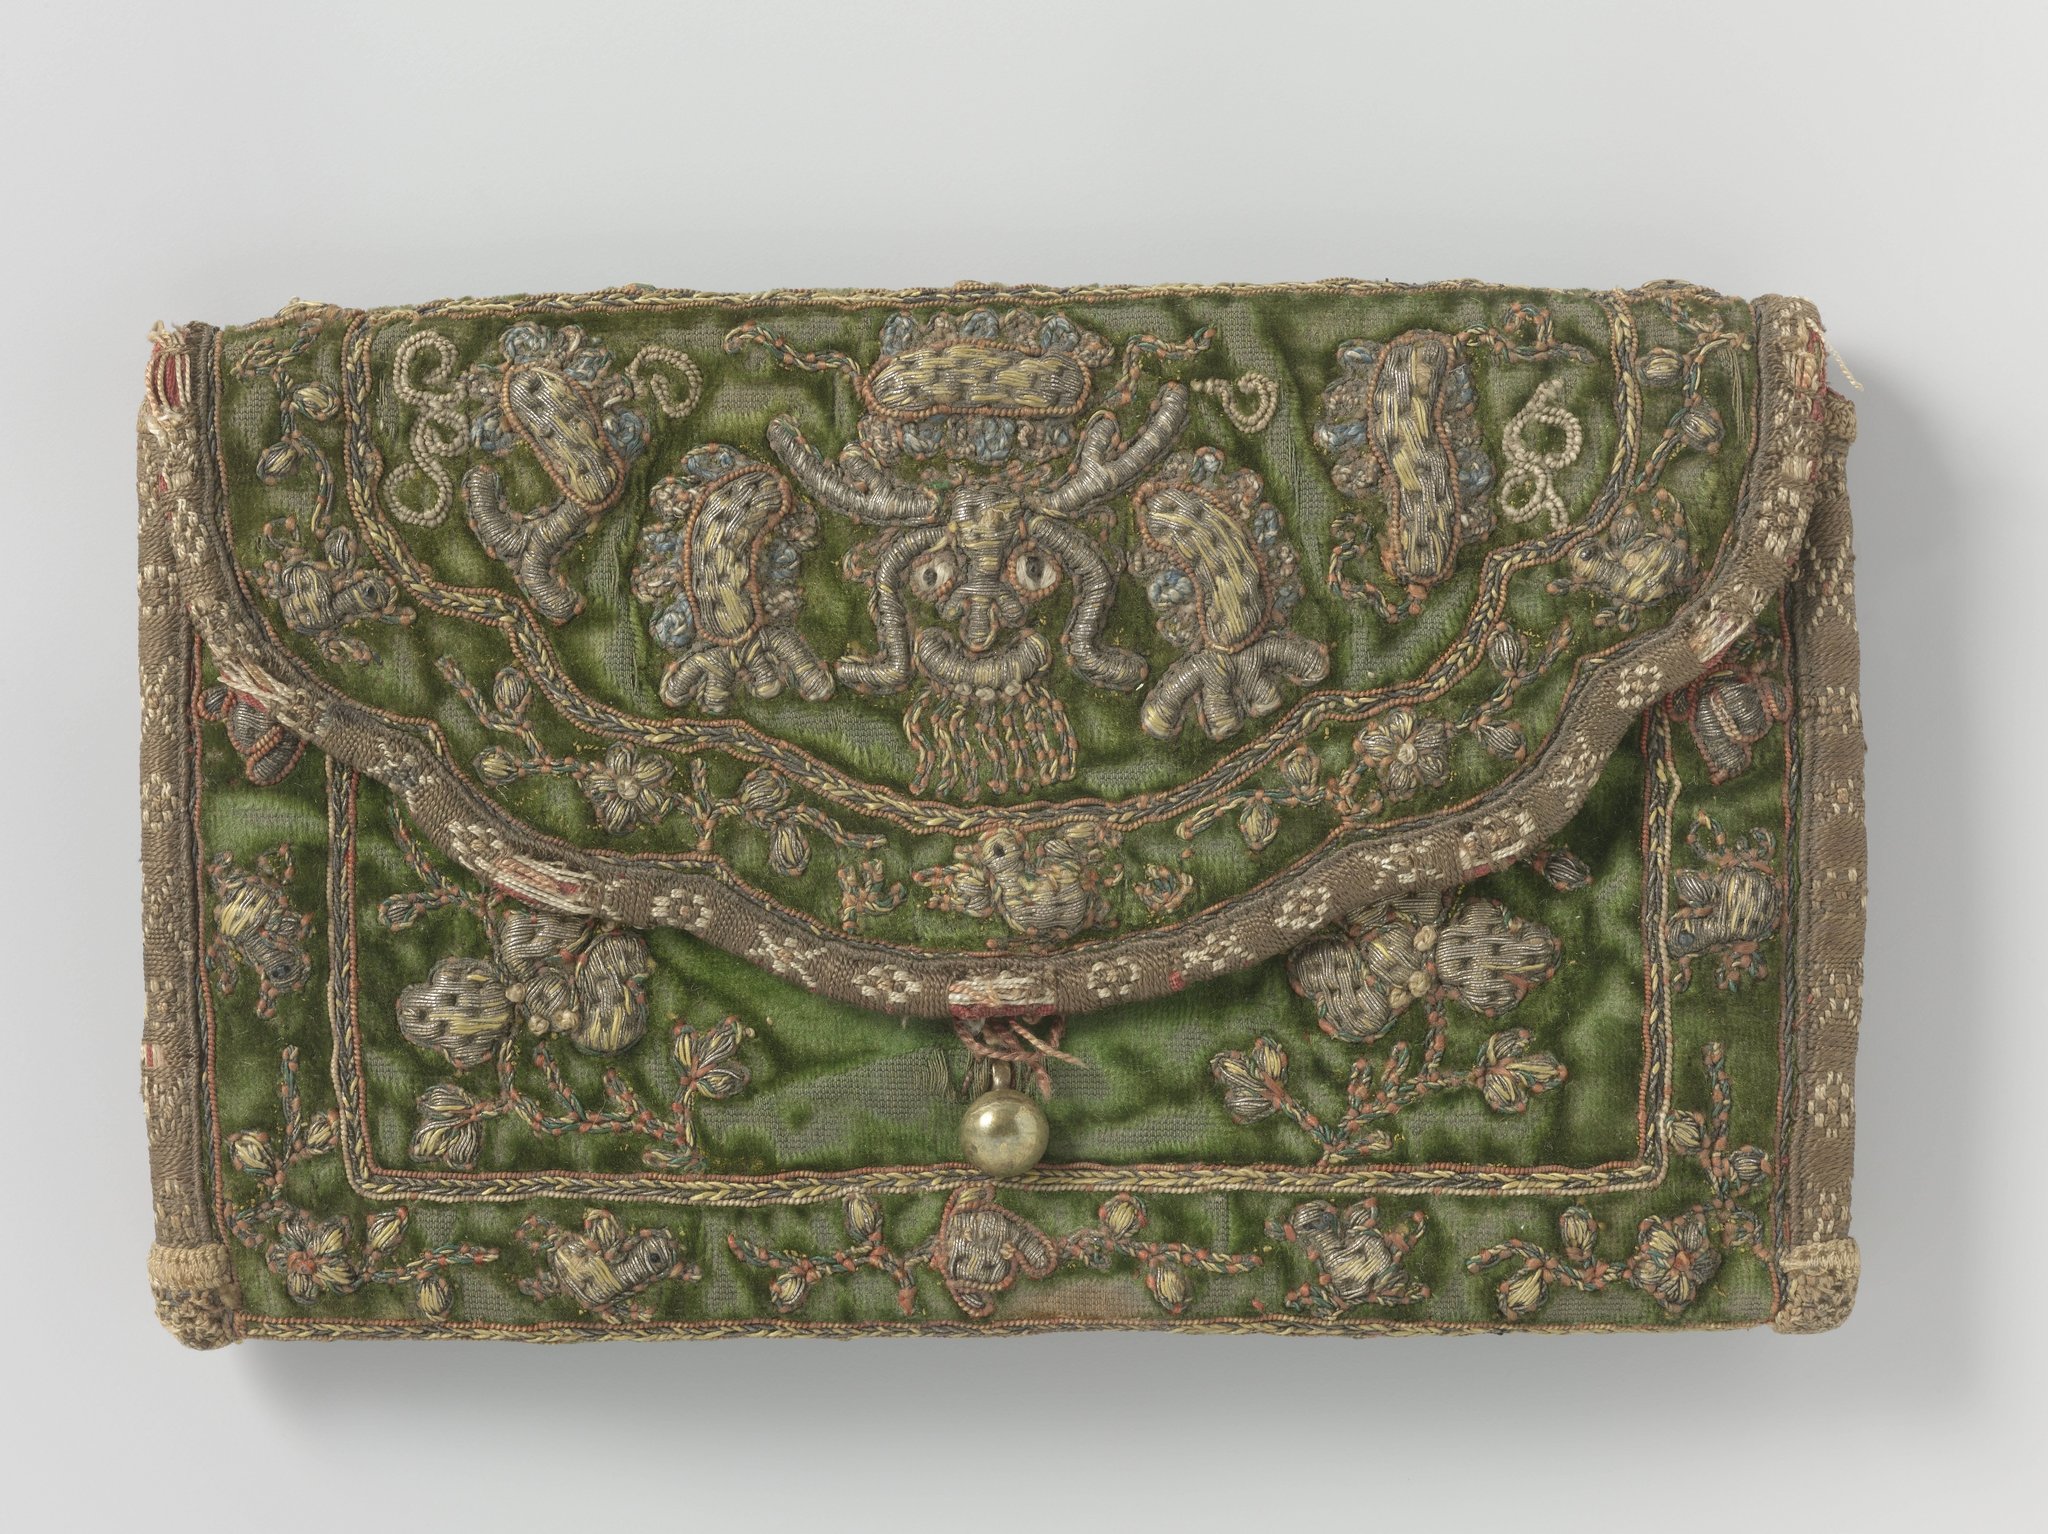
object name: brieventas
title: Brieventas in een envelopmodel van groen fluweel, geborduurd met een maskerachtig gezicht op voorkant en een fantasie dier op de achterkant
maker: Anonymous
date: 1700-1715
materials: copper, silk, thread, velvet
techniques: cutting, embroidered, forging, gilding, weave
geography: europe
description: Brieventas in een plat envelopmodel van groen fluweel, waarop in reliëf met zilverdraad een maskerachtig gezicht op voorkant en een fantasie dier op de achterkant geborduurd, beide omringd door een lijst van bloemen en kleine vogels. De rand van de tas is afgezet met een boord van bruin zijdedraad met ecrukleurige ornamenten. De twee onderste hoeken zijn met borduursteken verstevigd. De voering is van onversierd rood katoen. Aan de binnenkant twee gelijke vakken, verstevigd met papier. De klep sluit door middel van een lus van meerdere kleuren zijdendraad en een koperen bol.